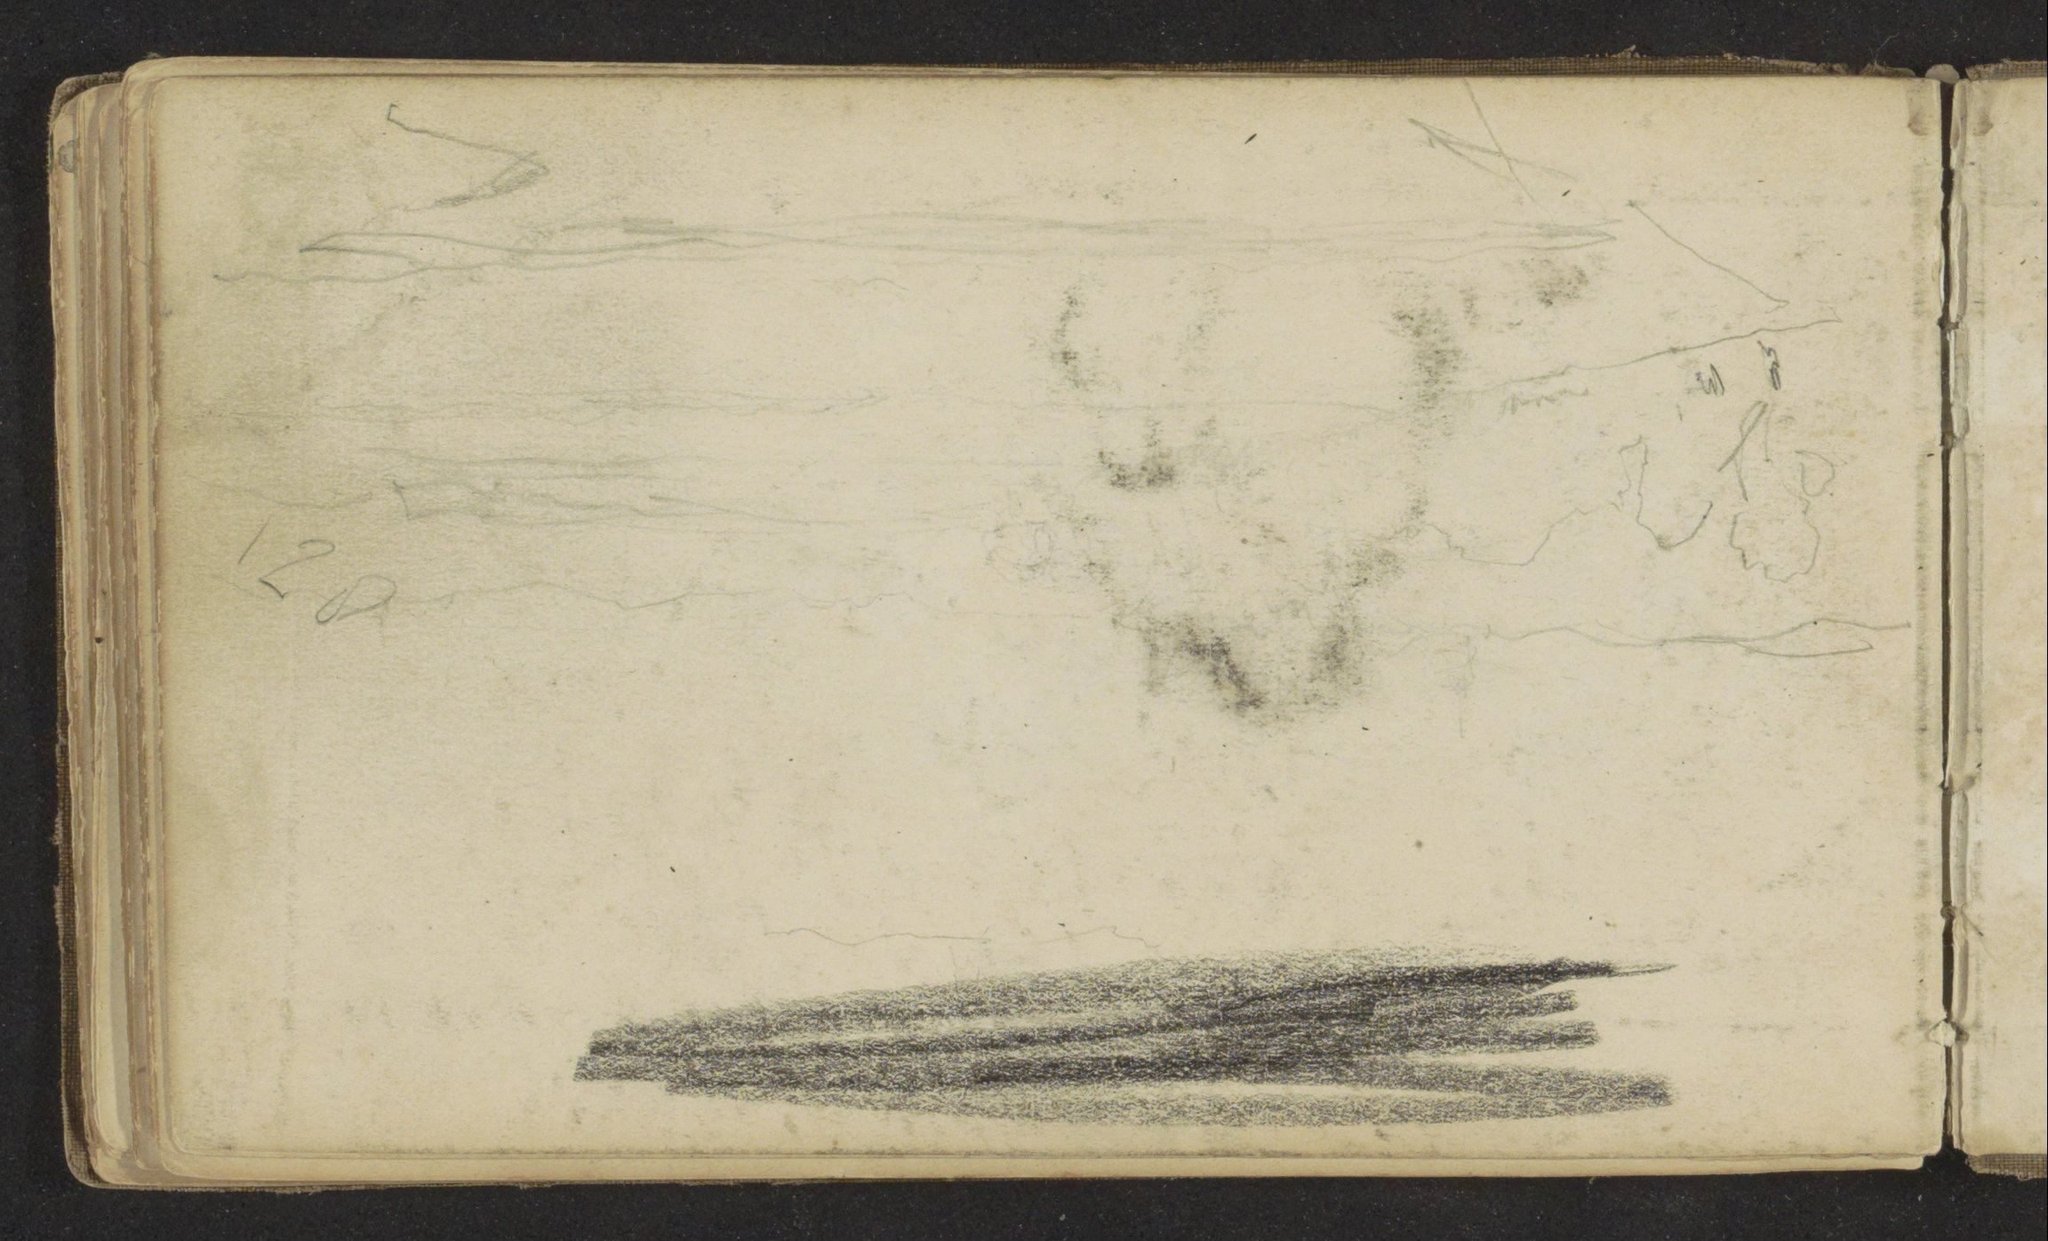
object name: sketchbook leaf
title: Landschap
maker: johan hendrik weissenbruch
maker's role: draughtsman, painter, print maker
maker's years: 1824-1903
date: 1834-1903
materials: paper, pencil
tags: landscapes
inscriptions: number: ‘128’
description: Blad 43 verso uit een schetsboek met 43 bladen.